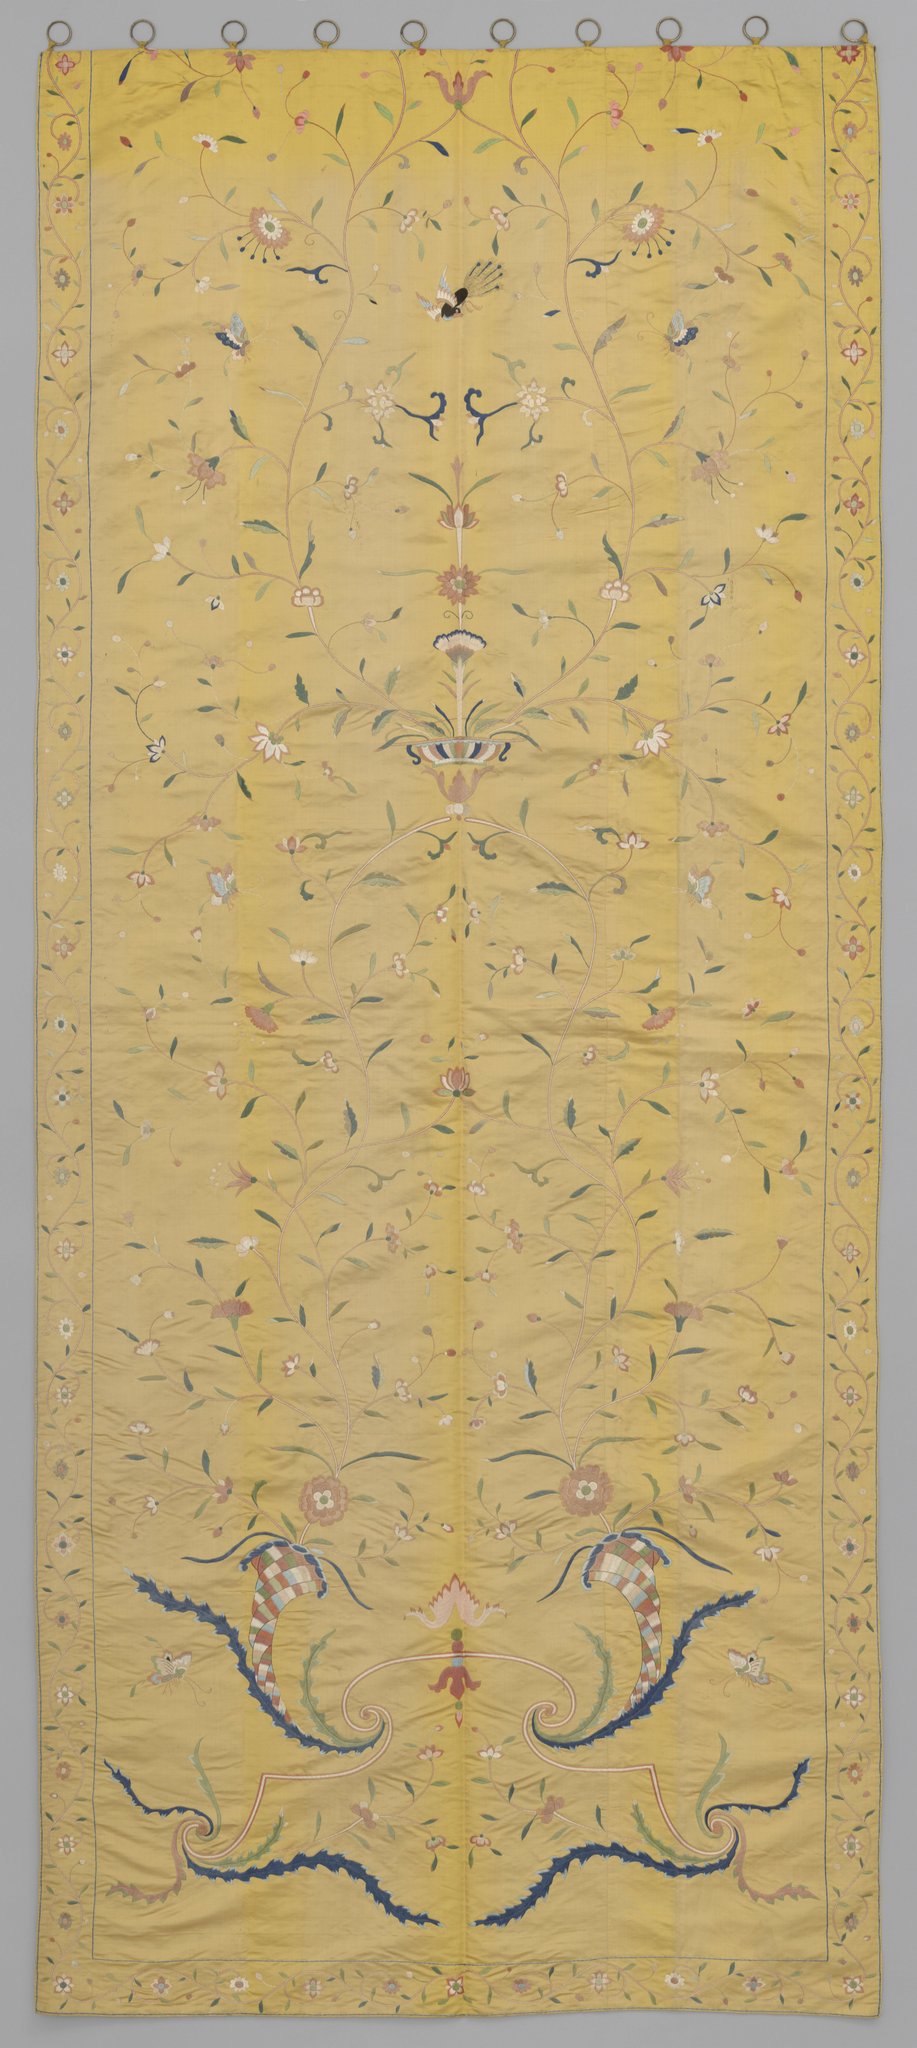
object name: bed curtain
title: Gordijn, geel, geborduurd met vazen, bloemranken, hoorn van overvloed, pauwen en vlinders.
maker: Anonymous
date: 1720-1740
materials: silk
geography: guangdong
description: Geel zijden gordijn van een bedgarnituur geborduurd met vazen, bloemranken, hoorns van overvloed, pauwen en vlinders in veelkleurige zijde, gevoerd met gele zijde. Bestemd voor de voorkant, linkerzijde.